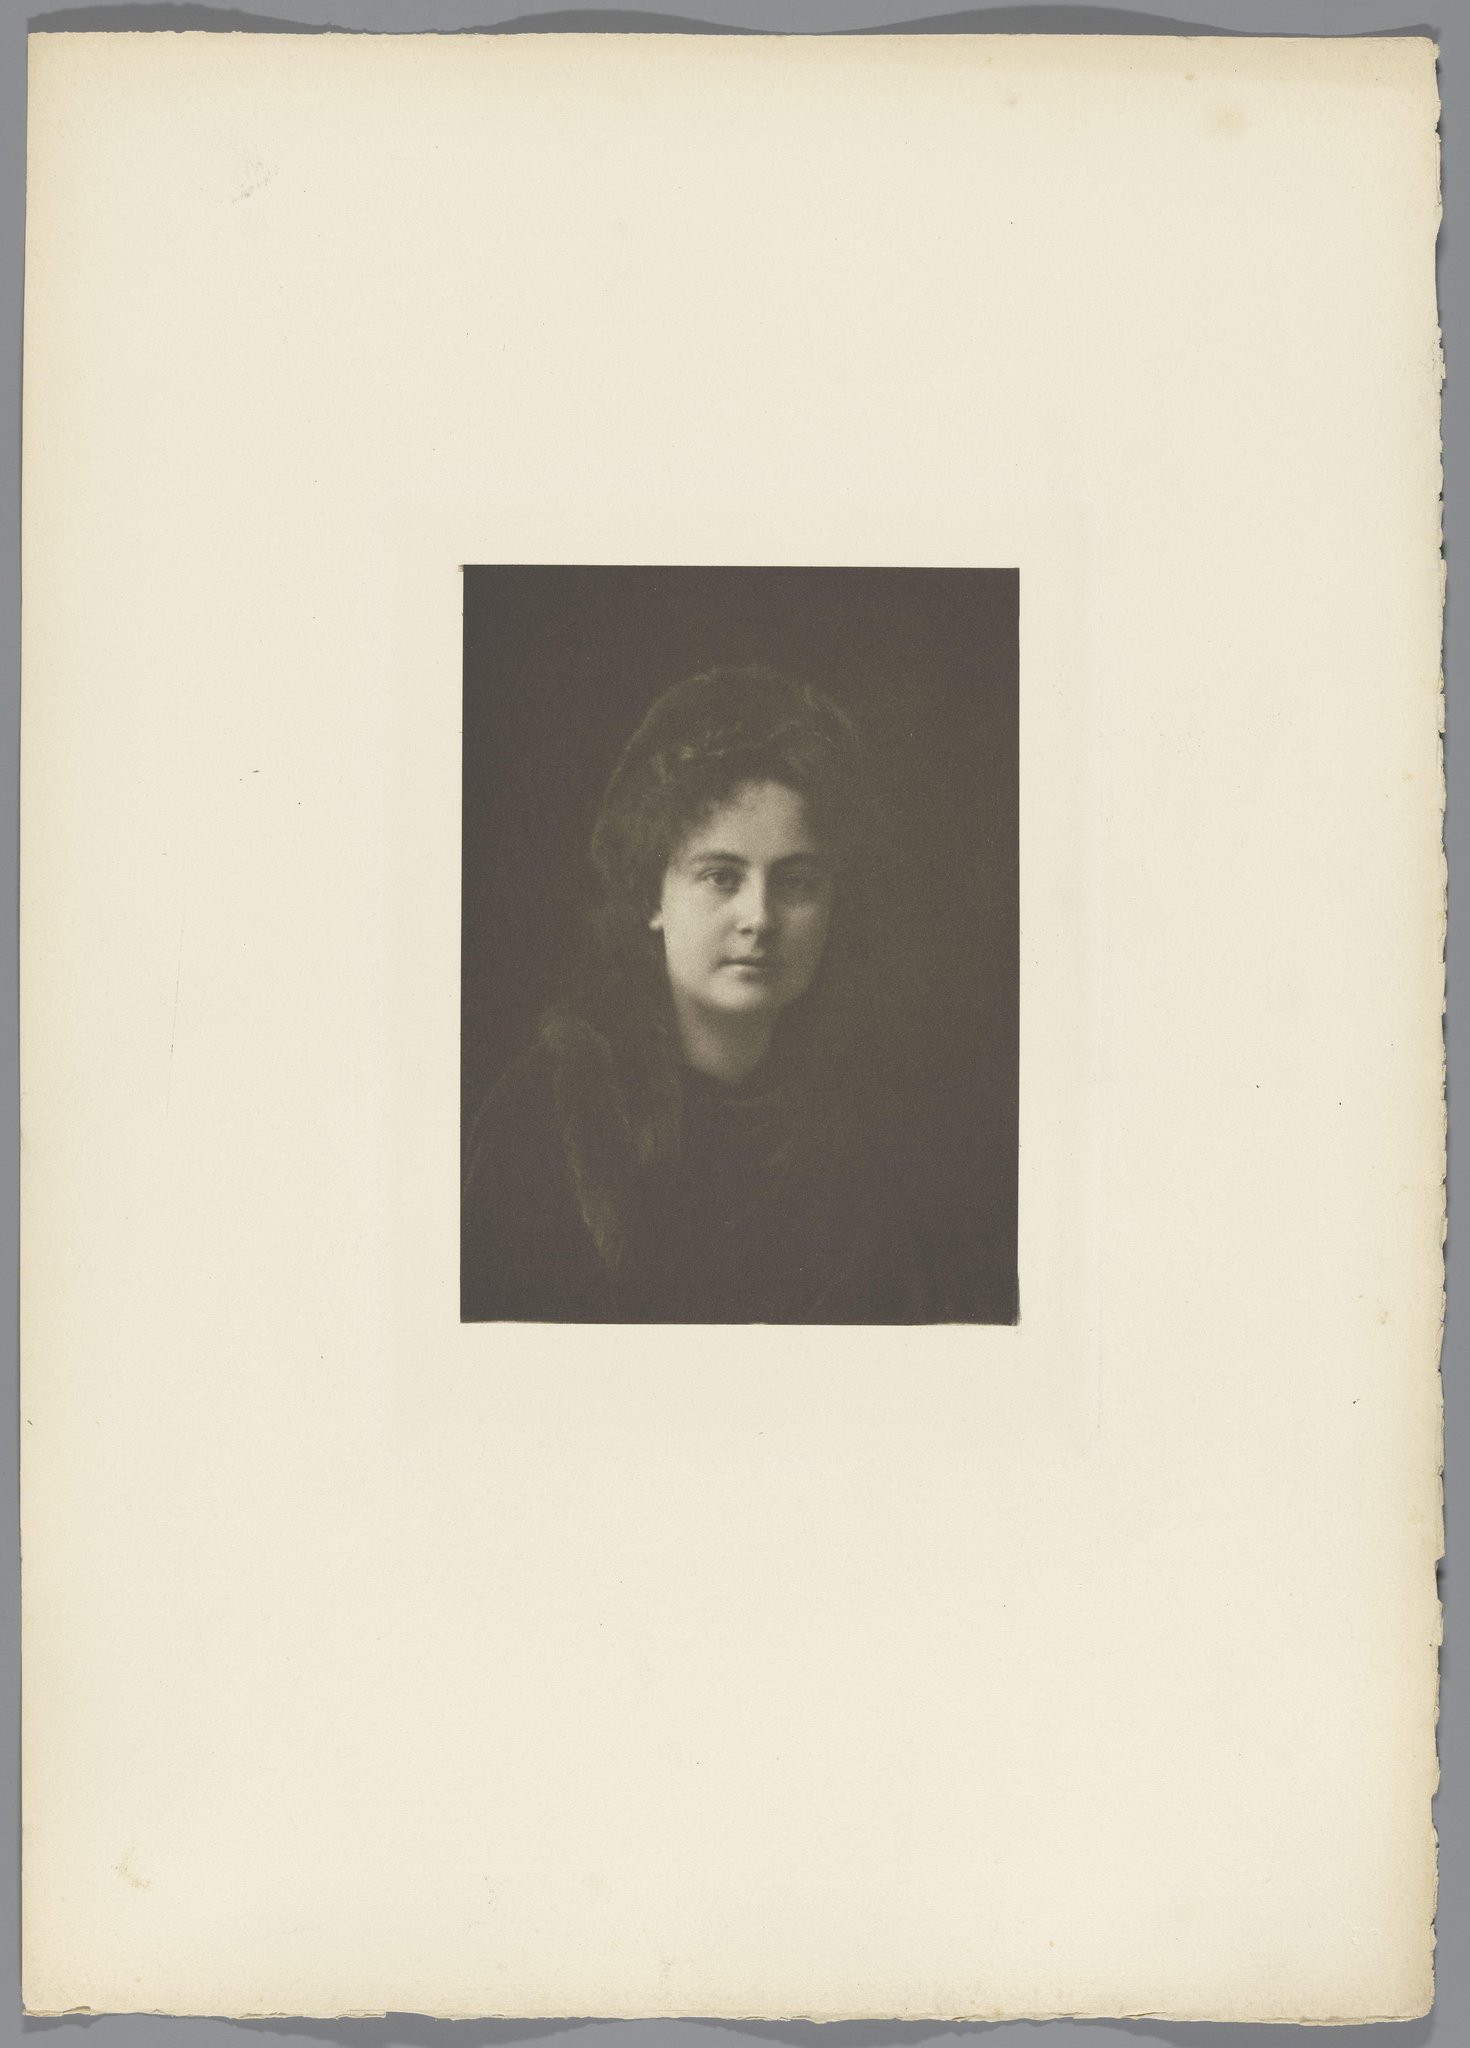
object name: photomechanical print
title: Portret van een onbekende jonge vrouw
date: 1891-1896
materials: paper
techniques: photoaquatint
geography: paris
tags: adolescent, young woman, maiden, historical persons not known by name - bb - woman